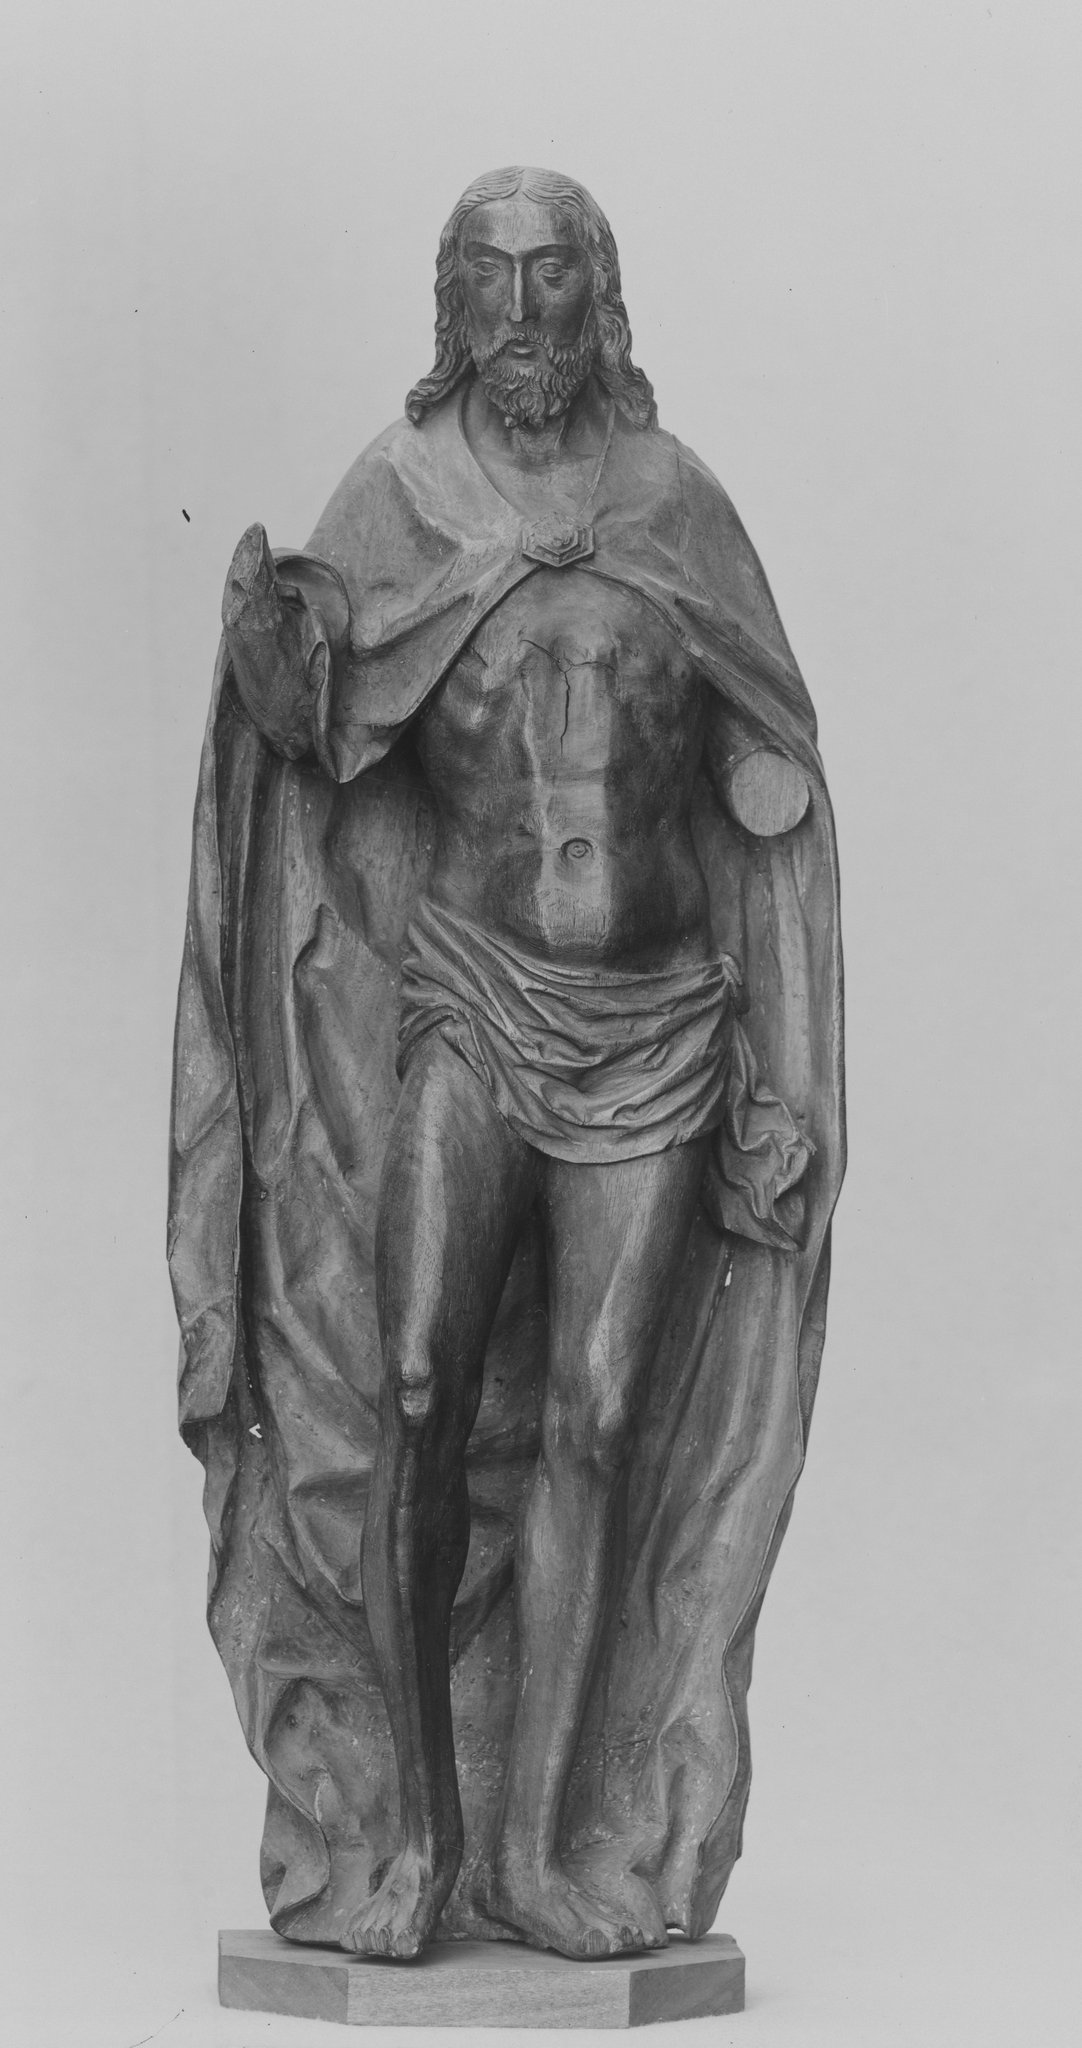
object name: wall statue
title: Christ of the Resurrection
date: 1501-1533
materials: wood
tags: christ